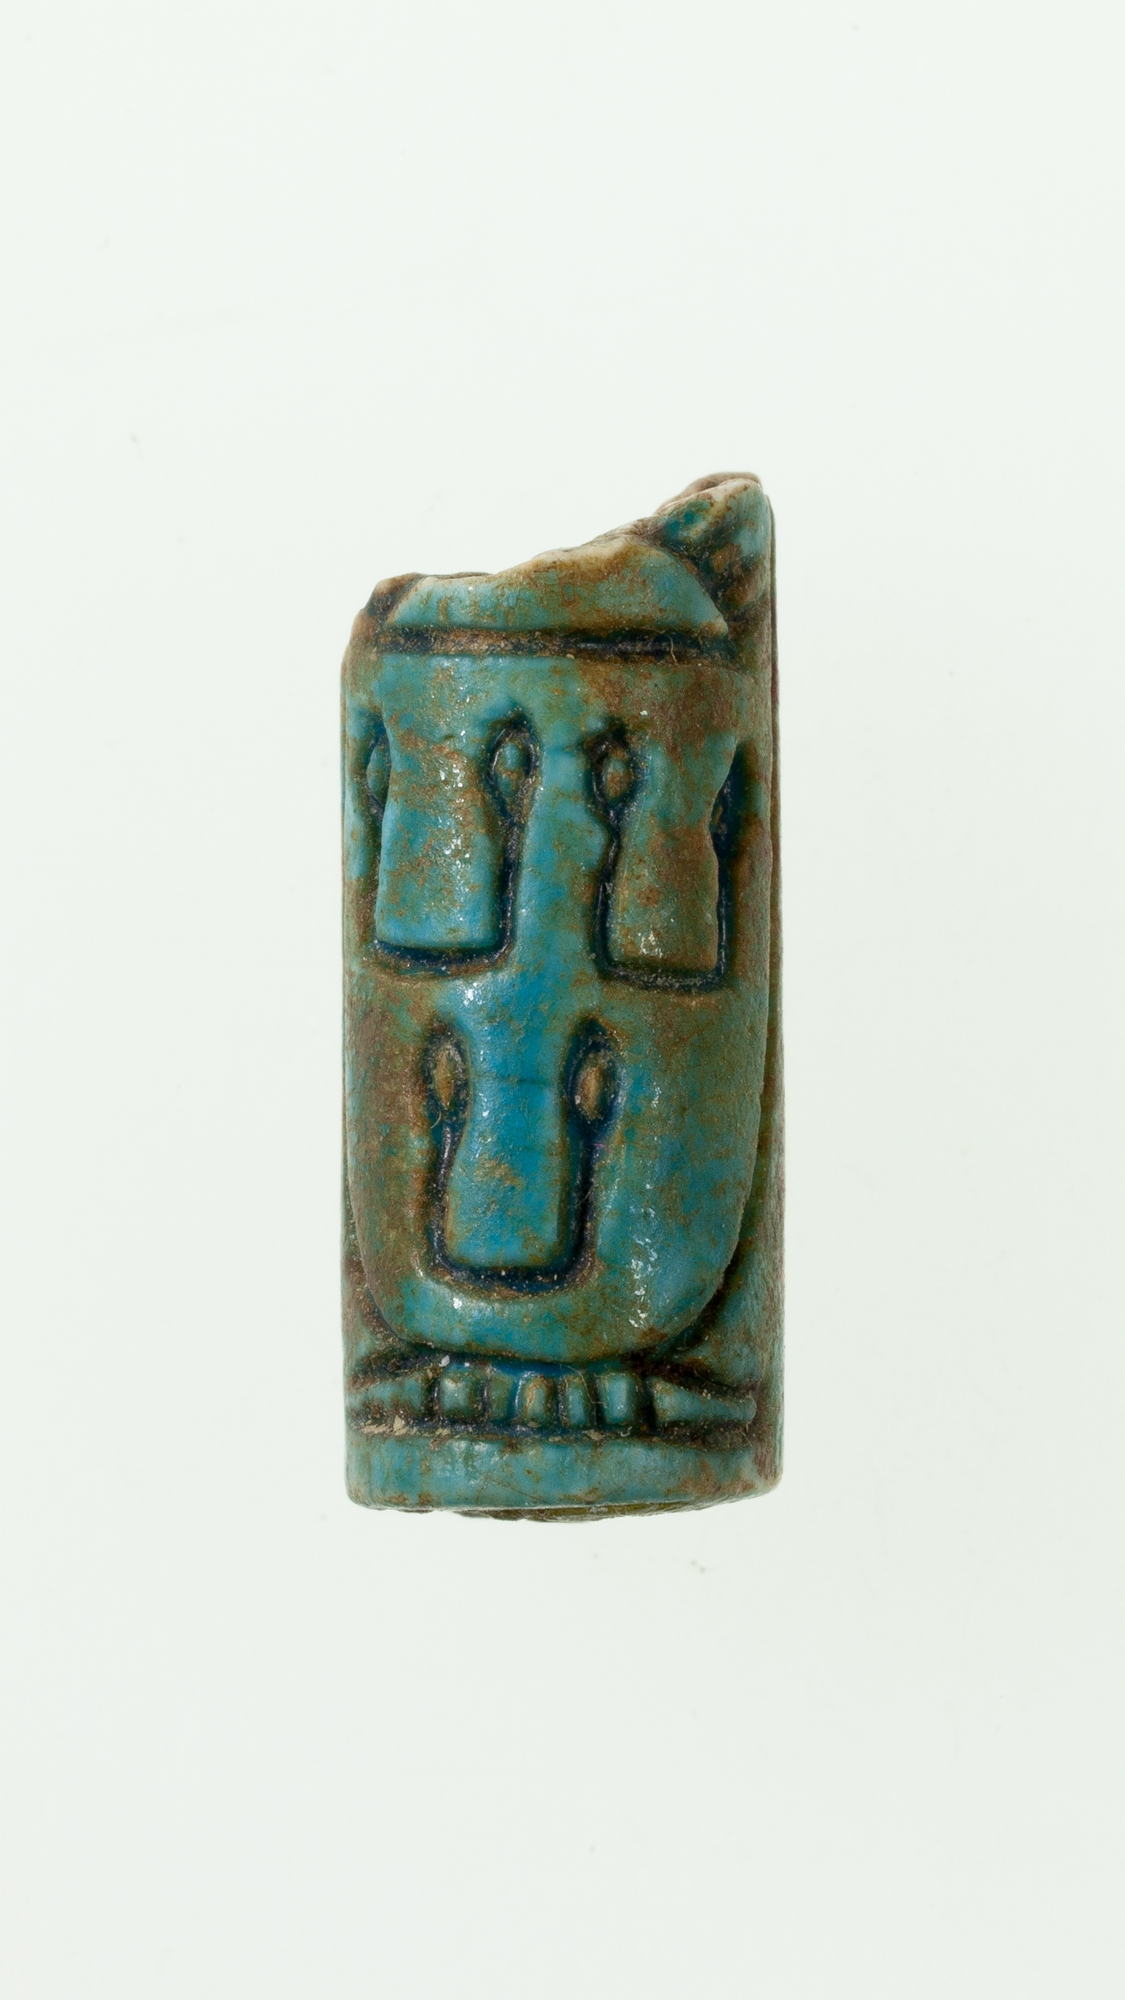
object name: cylinder seal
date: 1802-1550 BCE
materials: stone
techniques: glazing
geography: egypt